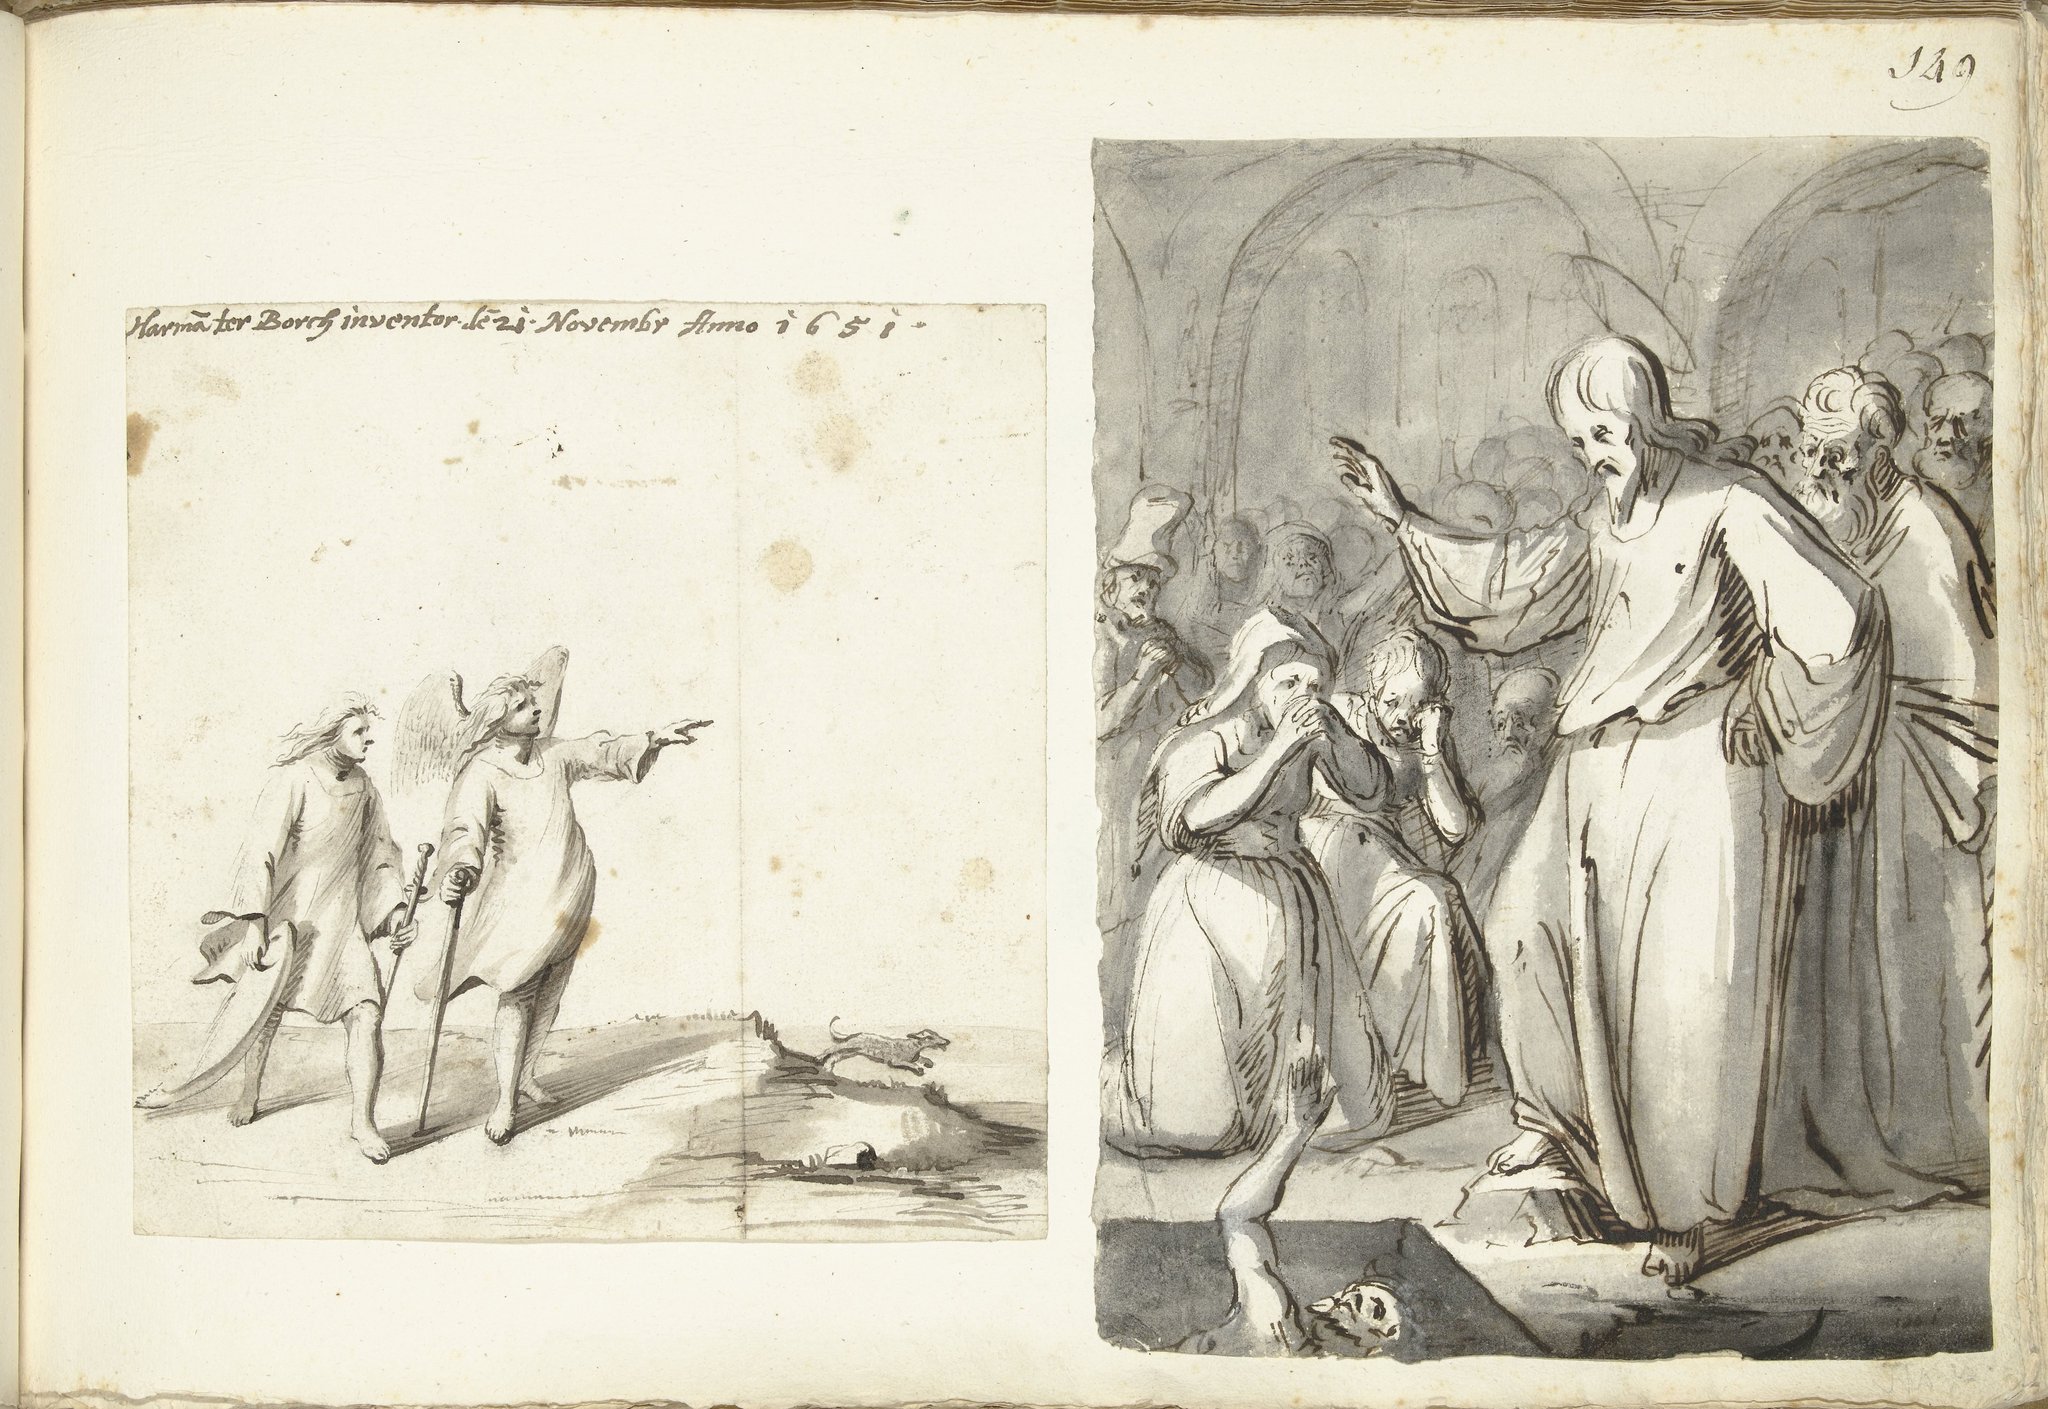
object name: drawing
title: Tobias en de engel, Opwekking van Lazarus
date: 1651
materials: chalk, ink, paper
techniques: brush, pen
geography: zwolle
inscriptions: date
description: Twee tekeningen naast elkaar op een blad geplakt.